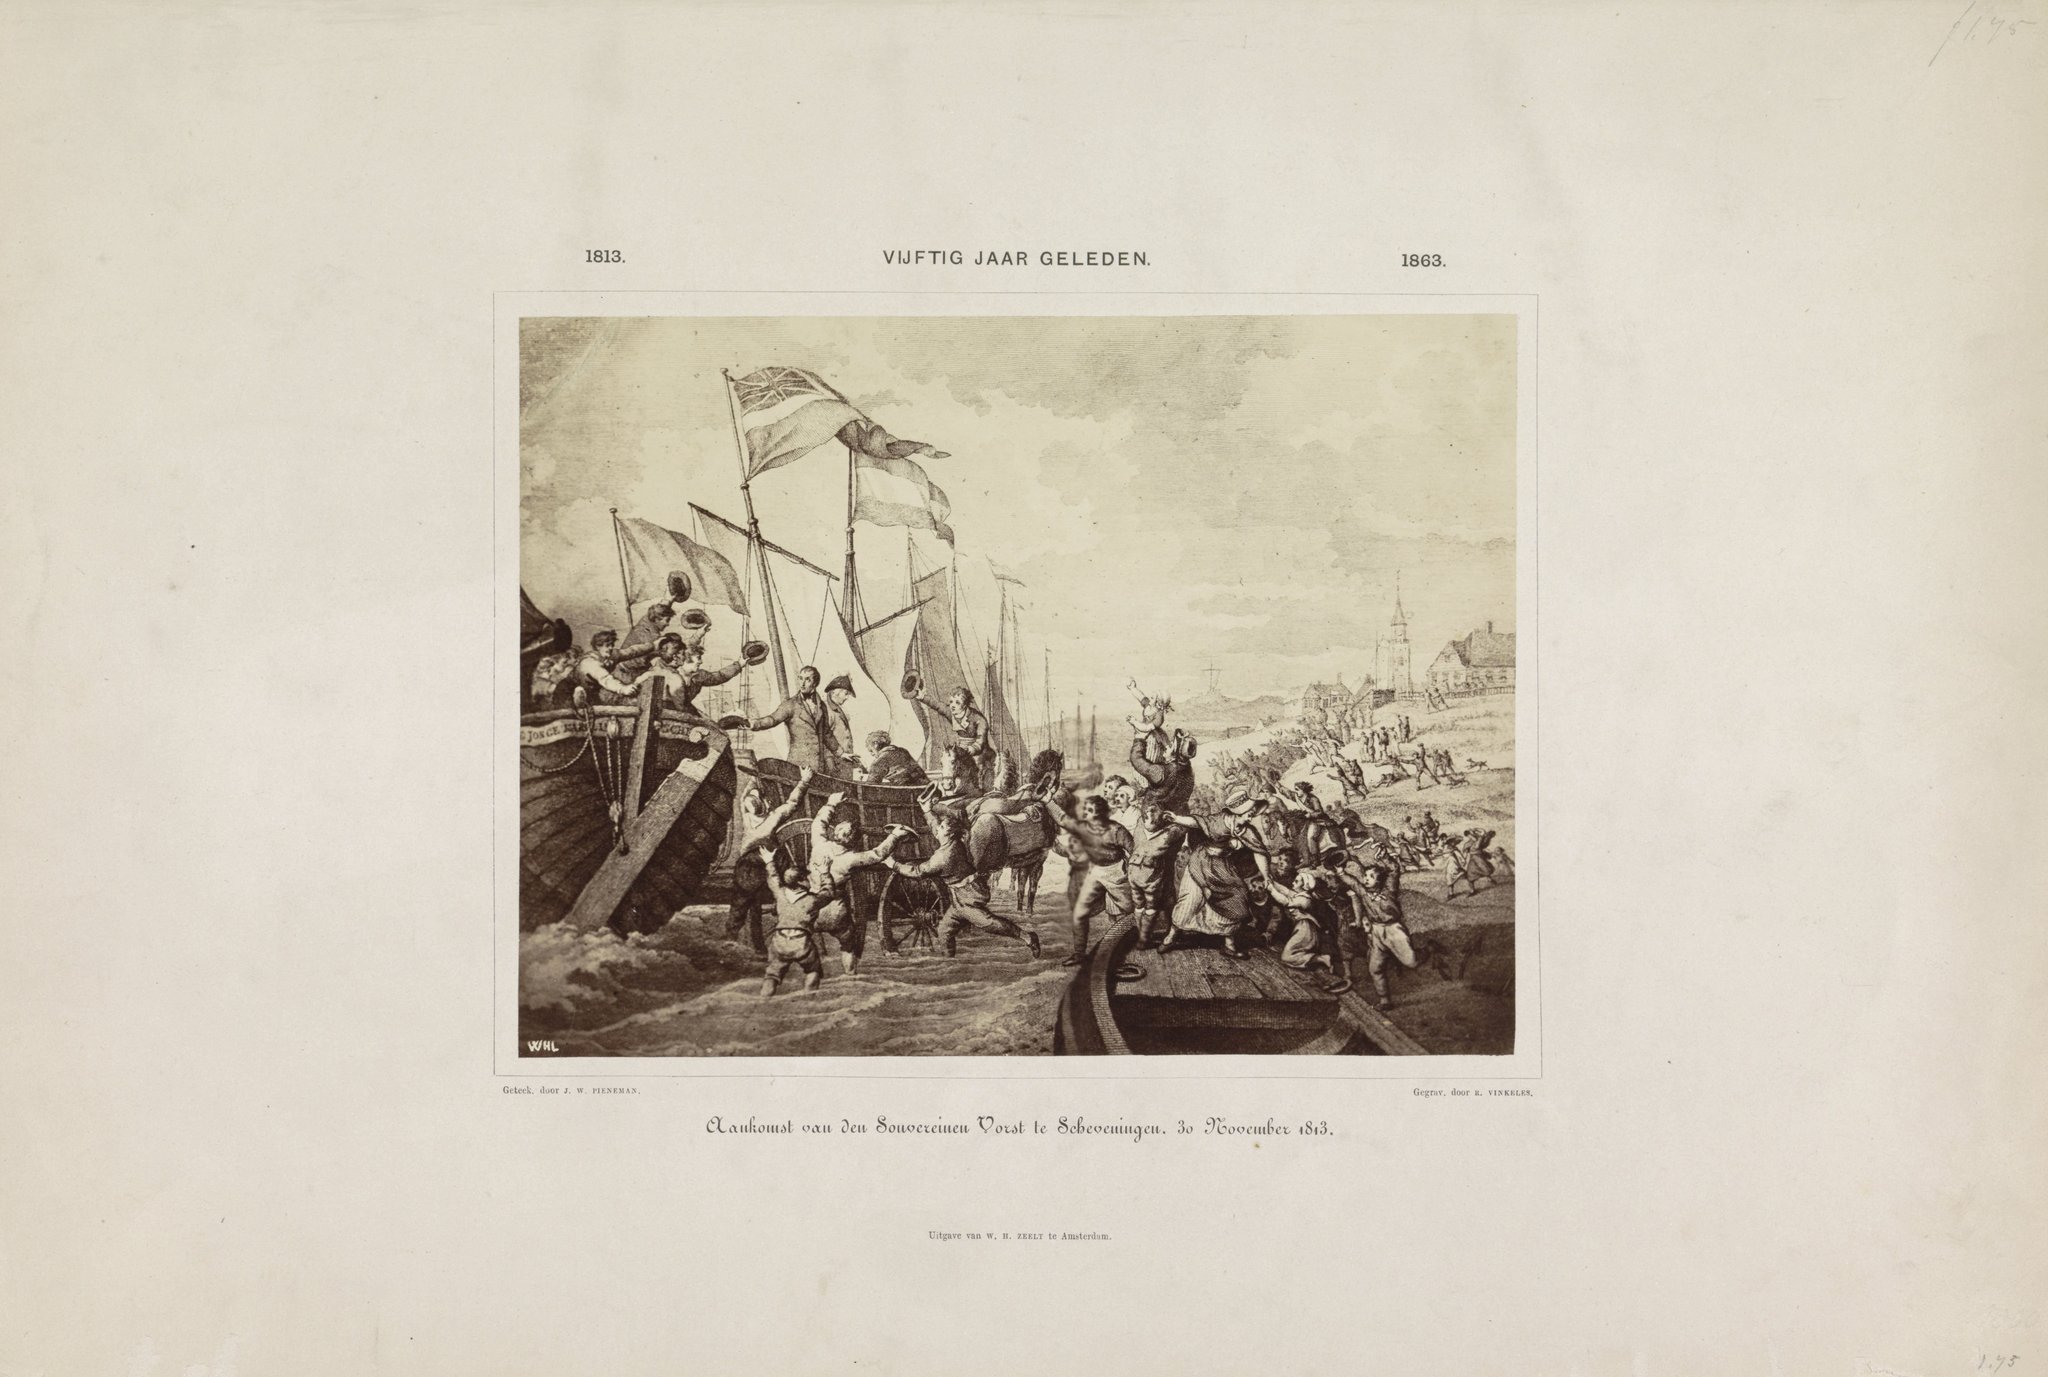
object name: photograph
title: Prent van de aankomst van koning Willem I te Scheveningen, 1813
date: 1863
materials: cardboard, paper, photographic support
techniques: albumen print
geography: netherlands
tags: the hague, william i of the netherlands, print, e.g.: engraving, etching, lithograph, being welcomed ~ travelling, homage to a ruler, landing of william frederick i (1813)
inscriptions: collector's mark: Lugt 2228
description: Fotoreproductie van de ingekleurde prent door R. Vinkeles naar tekening van J.W. Pieneman van de aankomst van de souvereine vorst te Scheveningen op 30 november. Ter gelegenheid van het vijftigjarig jubileum van Nederlands onafhankelijkheid.